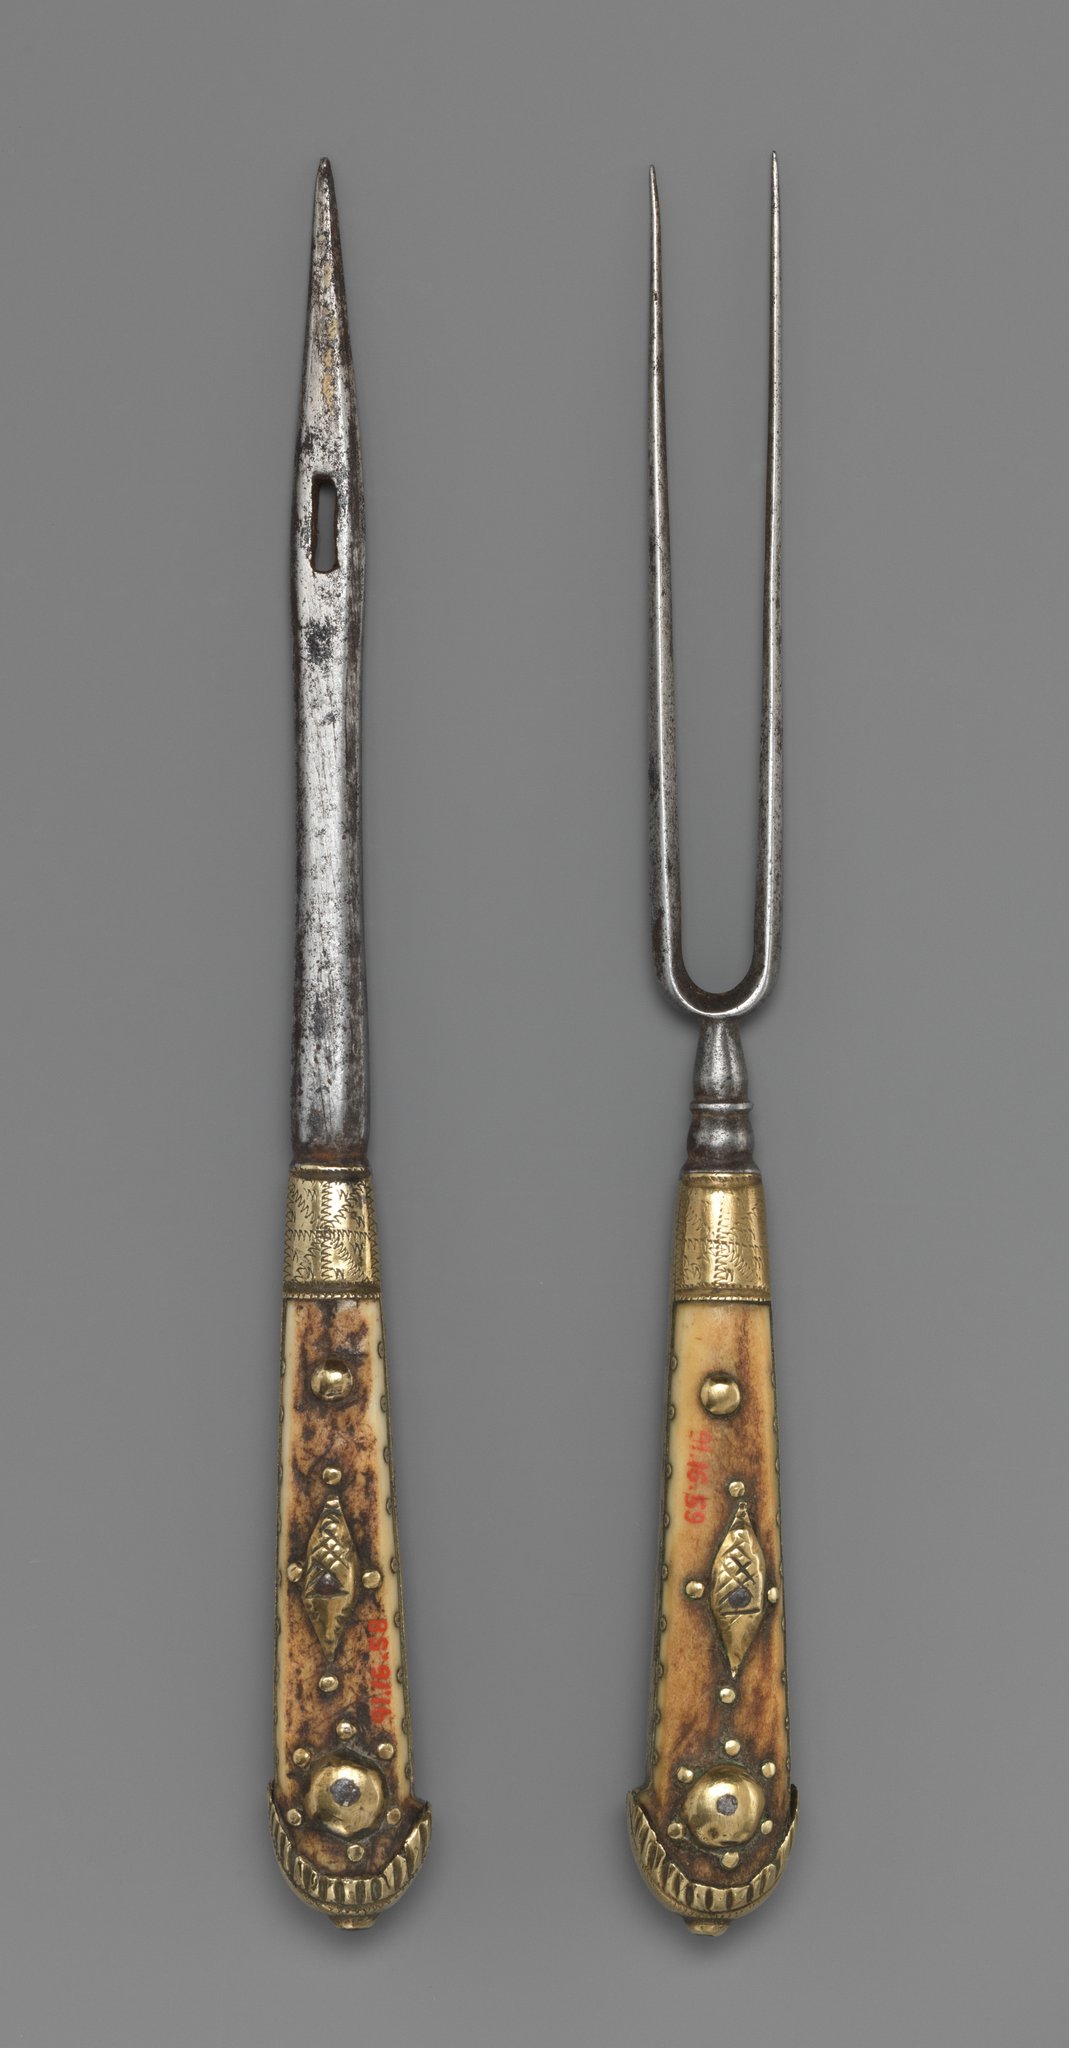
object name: skewer needle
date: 1701-1800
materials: brass, steel